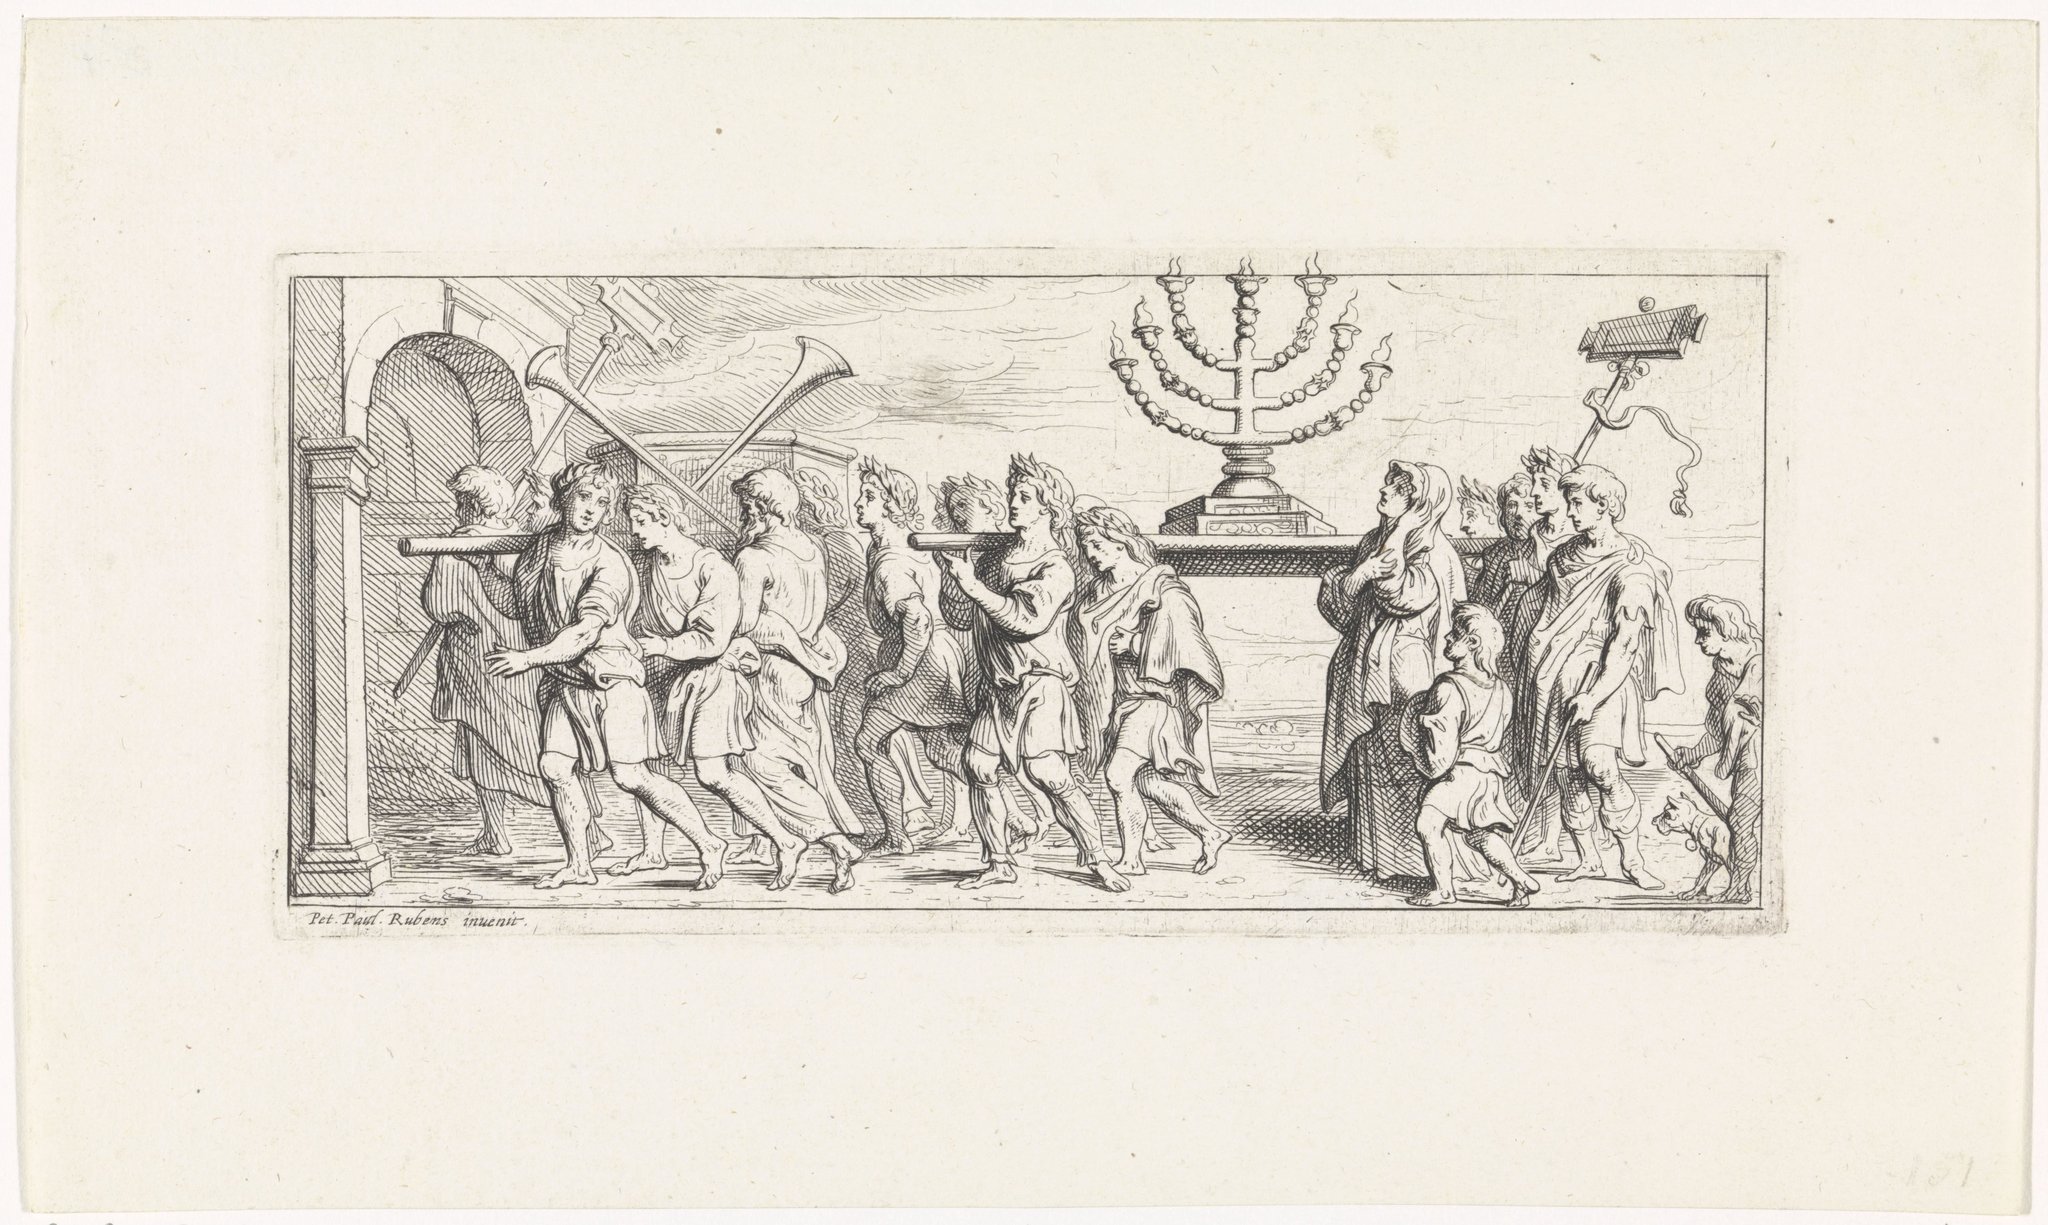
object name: print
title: Triomfoptocht met de zevenarmige kandelaar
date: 1642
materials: paper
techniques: engraving, etching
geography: antwerp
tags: emperor titus destroying the temple of jerusalem (+ variant), 'menorah', golden seven-branched candlestick, kept in the tabernacle, piece of sculpture, reproduction of a piece of sculpture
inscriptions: collector's mark: Lugt 240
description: Prent gebruikt in: Gevartius, Casper. Pompa introitvs (...) Ferdinandi Avstriaci (...) a S. P. Q. Antverp. decreta et adornata; (...) cùm (...) Antverpiam auspicatissimo aduentu suo bearet, XV. kal. maii, ann. M.DC.XXXV. Antwerpen: Jan van Meurs, 1642, p. 94. Kopie naar de illustratie in: Choul, Guillaume de. Discours de la religion des anciens Romains: de la castrametation & discipline militaire d'iceux, des bains & antiques exercitations Grecques & Romaines. Lyon 1581.